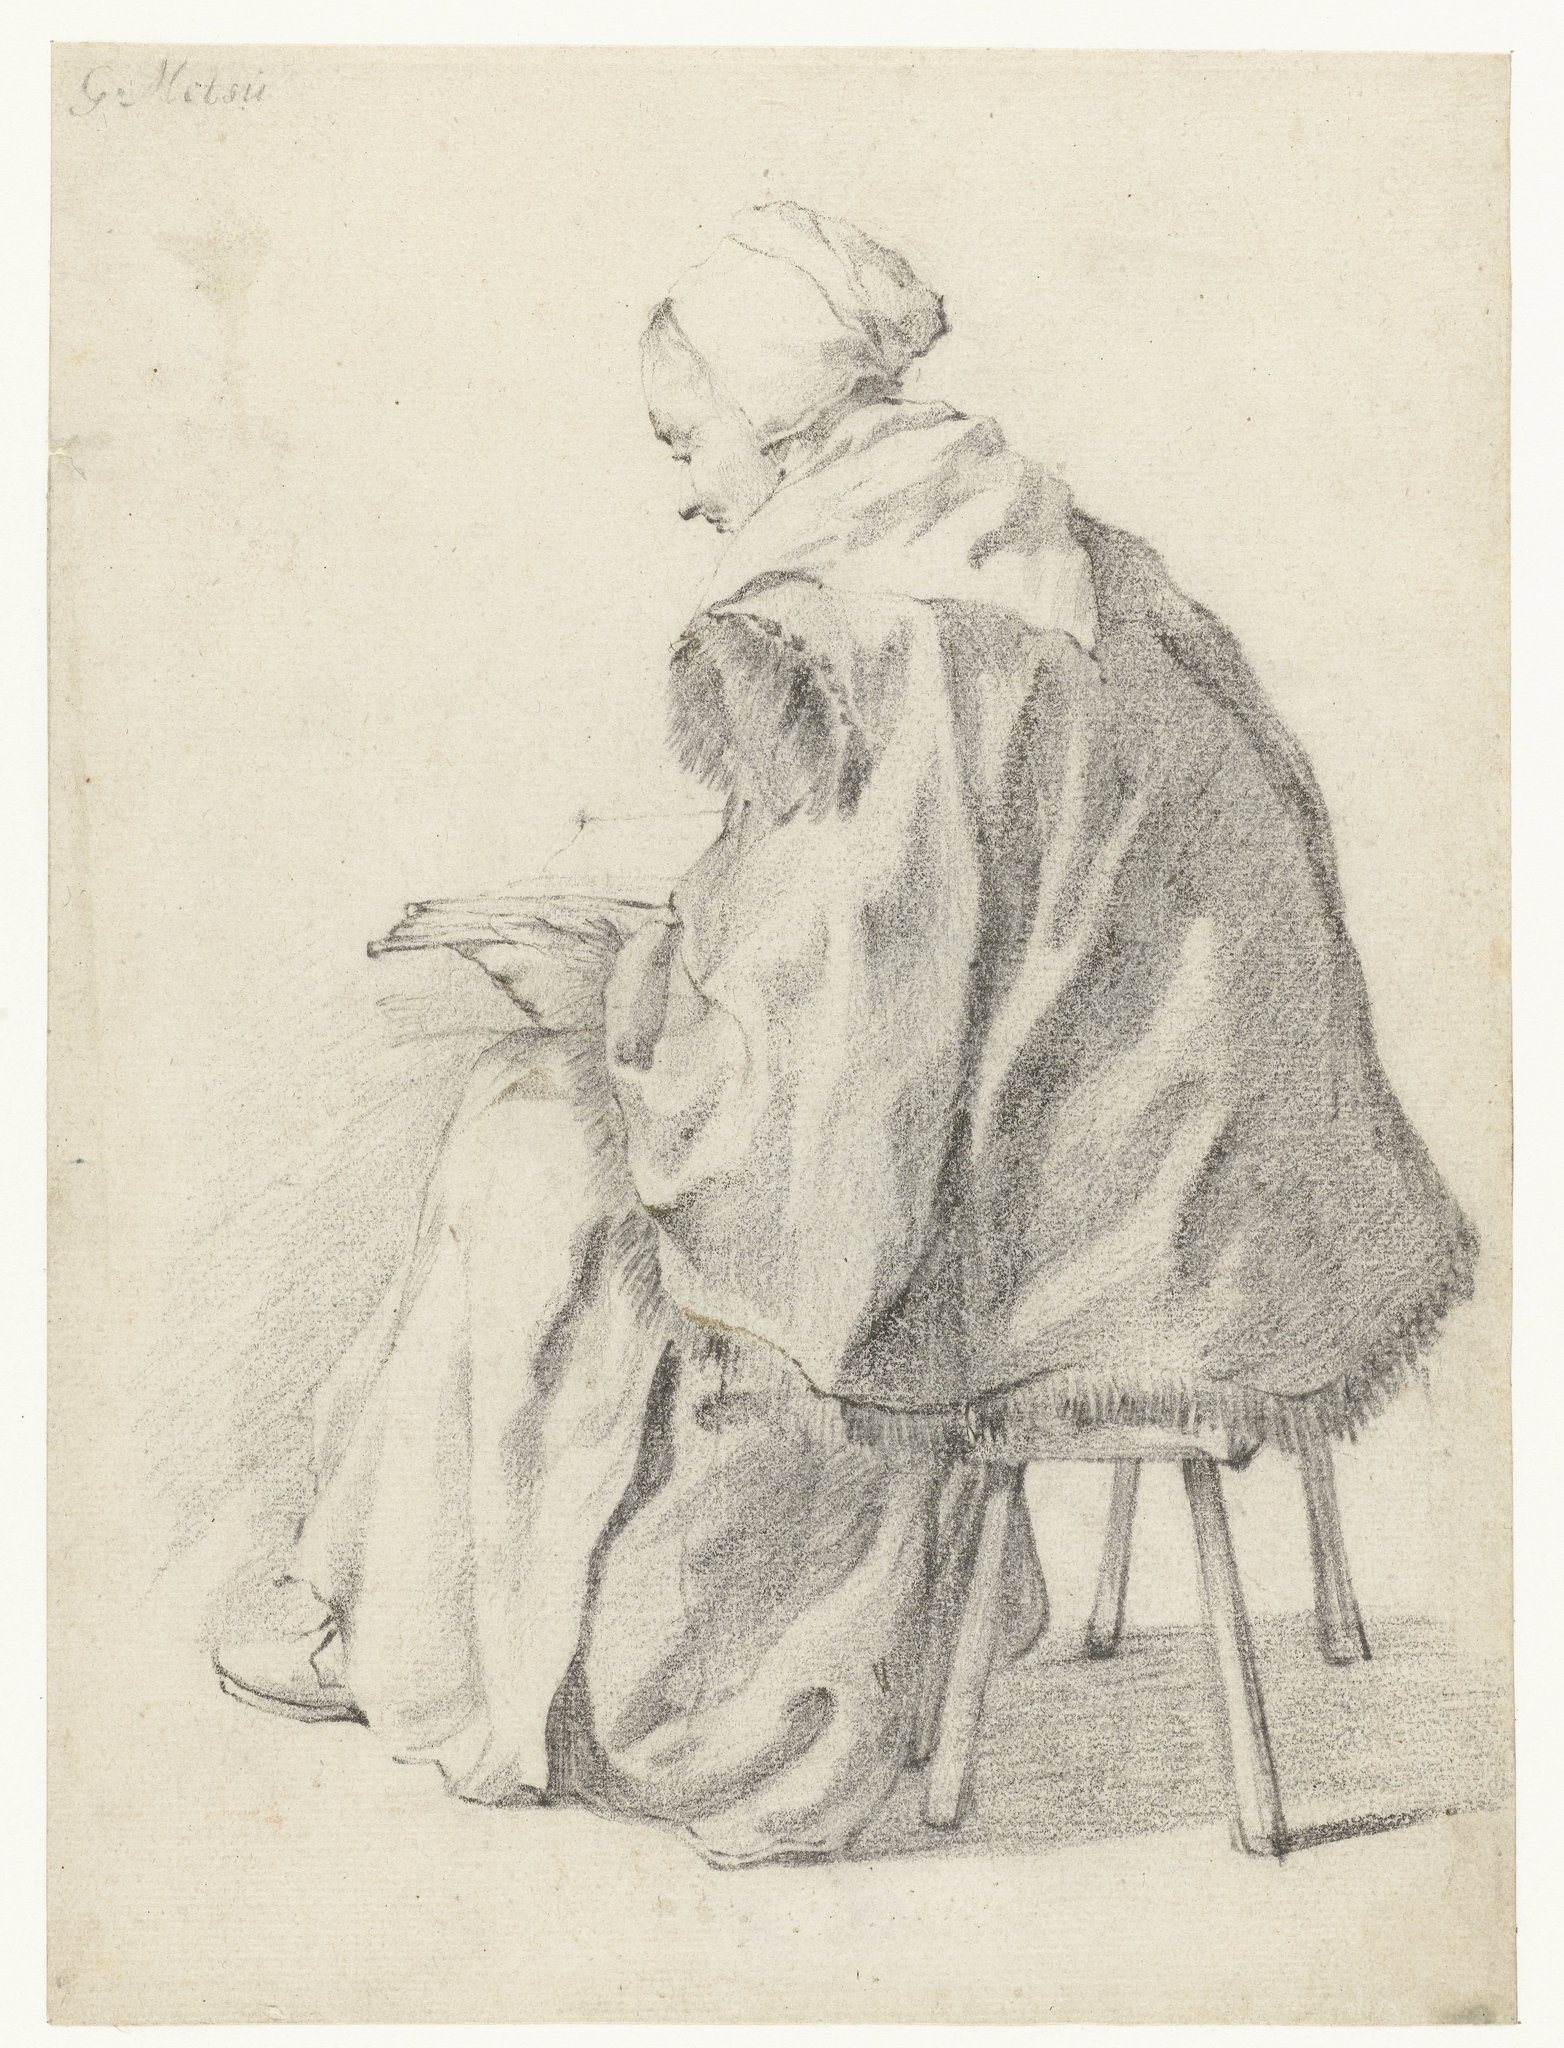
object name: design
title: Seated Woman, Reading a Book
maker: constantijn verhout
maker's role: draughtsman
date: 1650-1660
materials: chalk, paper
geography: gouda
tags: reading, sitting figure - aa - female human figure